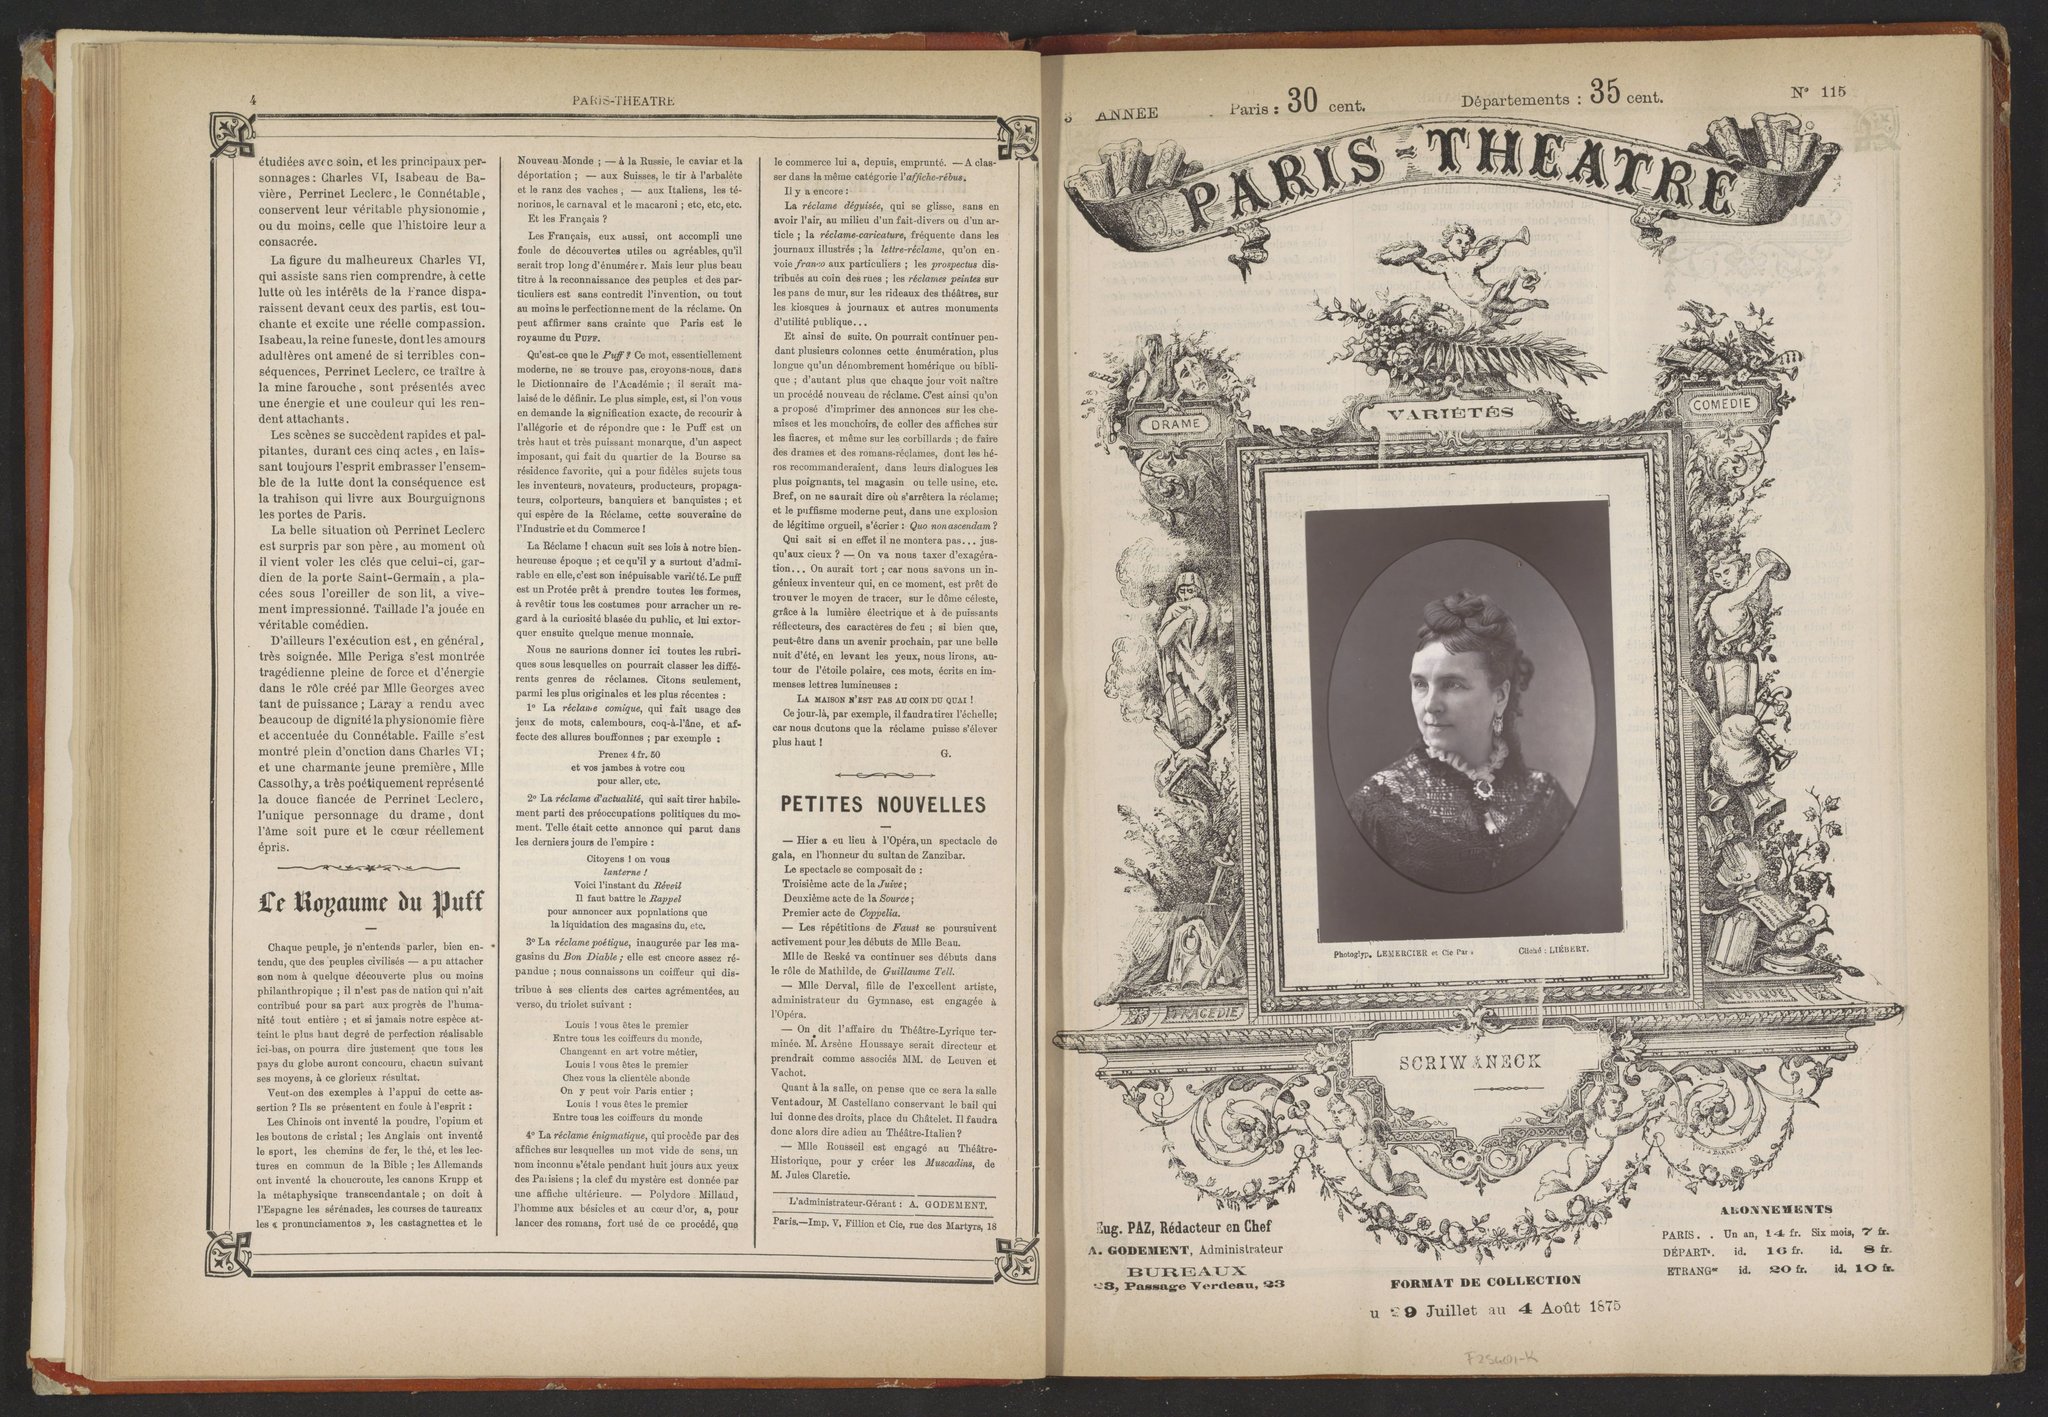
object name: photomechanical print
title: Portret van Augustine-Célestine Schriwaneck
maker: alphonse-justin liébert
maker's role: fotograaf, marinier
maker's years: 1827-1914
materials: paper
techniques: woodburytype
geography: paris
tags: portrait of actor, actress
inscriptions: number: ‘No 115’, inscription: ‘Du 29 Juillet ai 4 Août 1875’